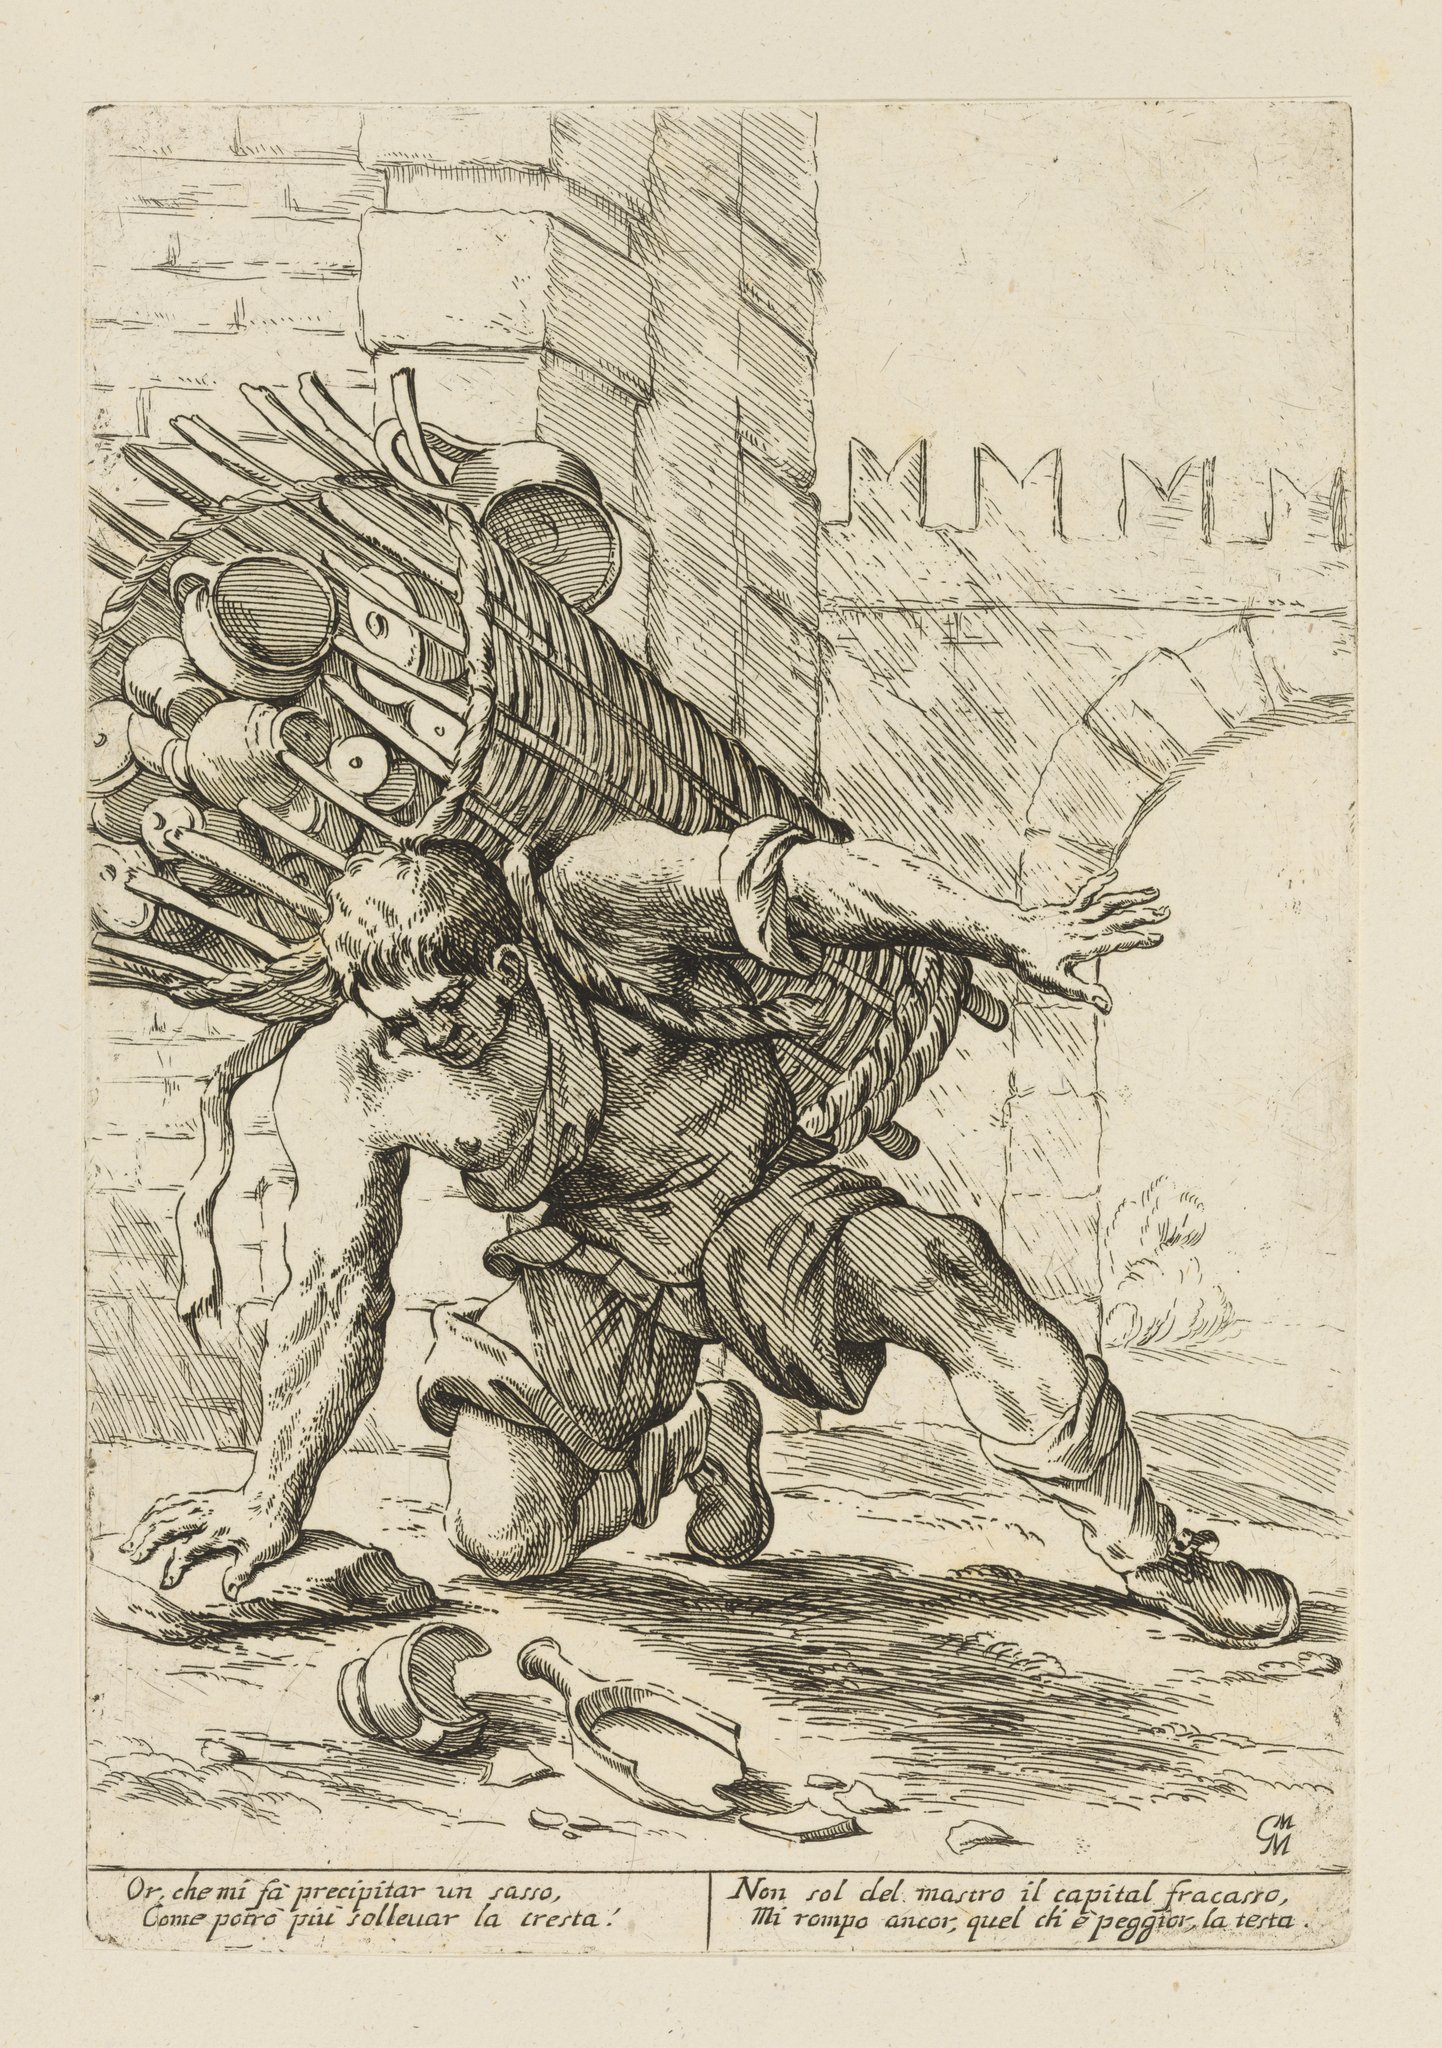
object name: print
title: Vendor of Erthenware Pots, from Di Bologna l'Arti per via D'An.ibal' Ca.rac, plate 4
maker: giuseppe maria mitelli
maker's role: artist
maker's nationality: italian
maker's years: 1634-1718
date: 1660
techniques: etching